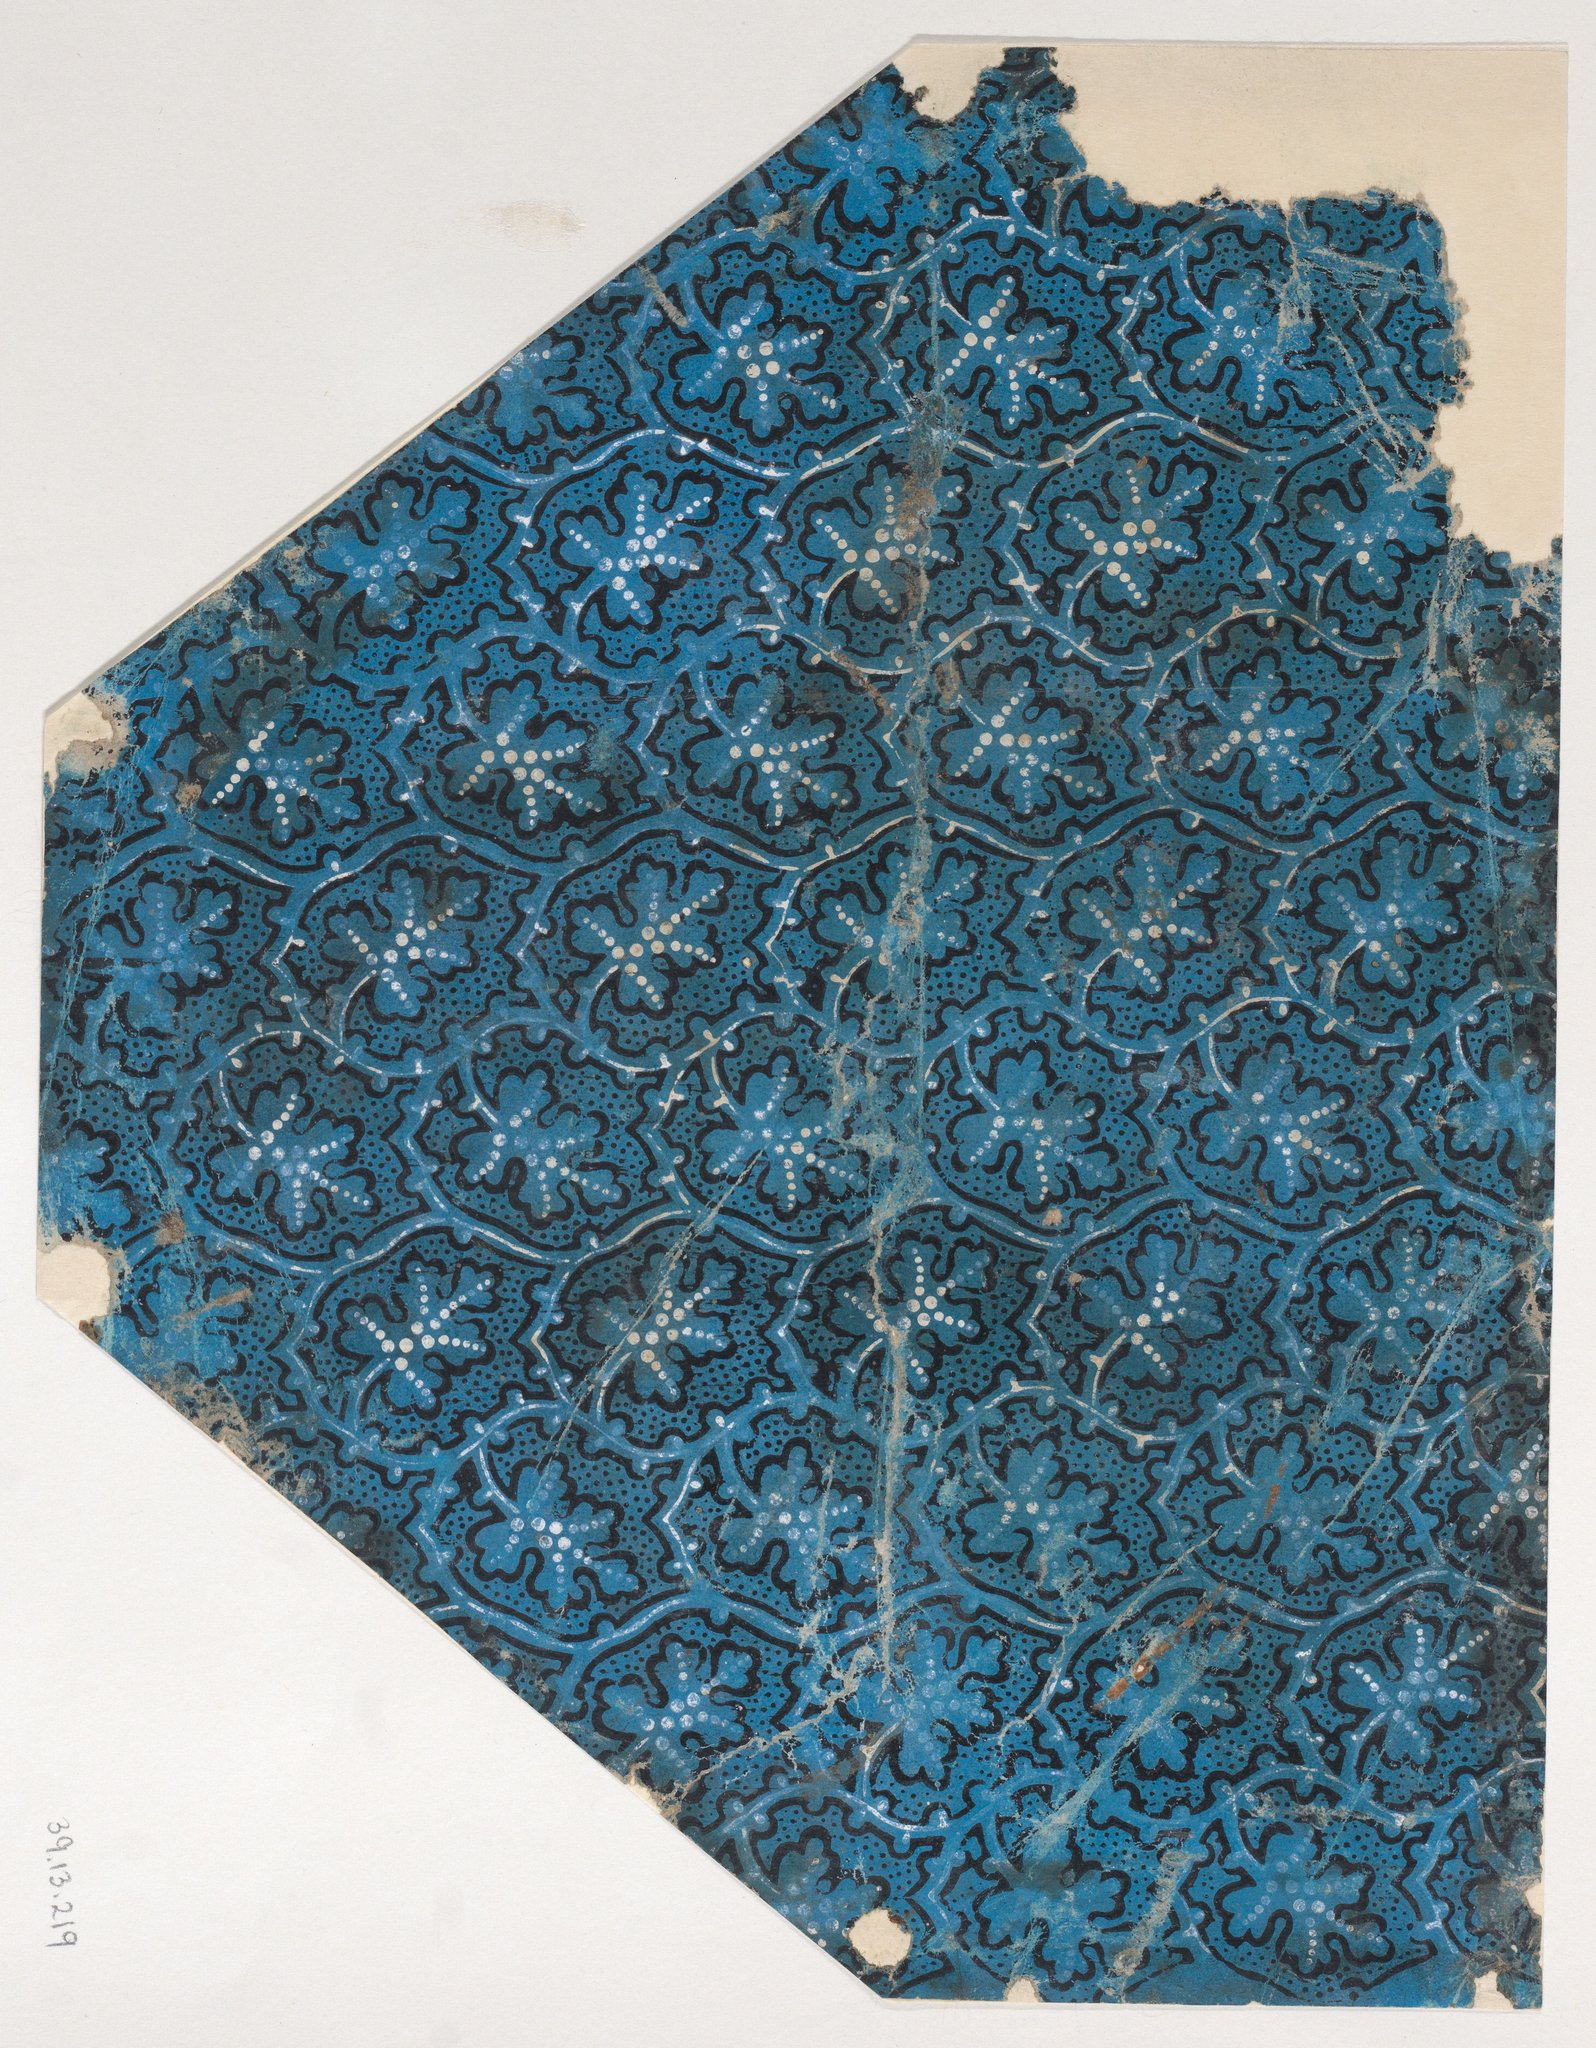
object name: print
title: Sheet with overall pattern of leaves, vines, and dots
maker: Anonymous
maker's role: artist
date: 1801-1900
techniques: relief print